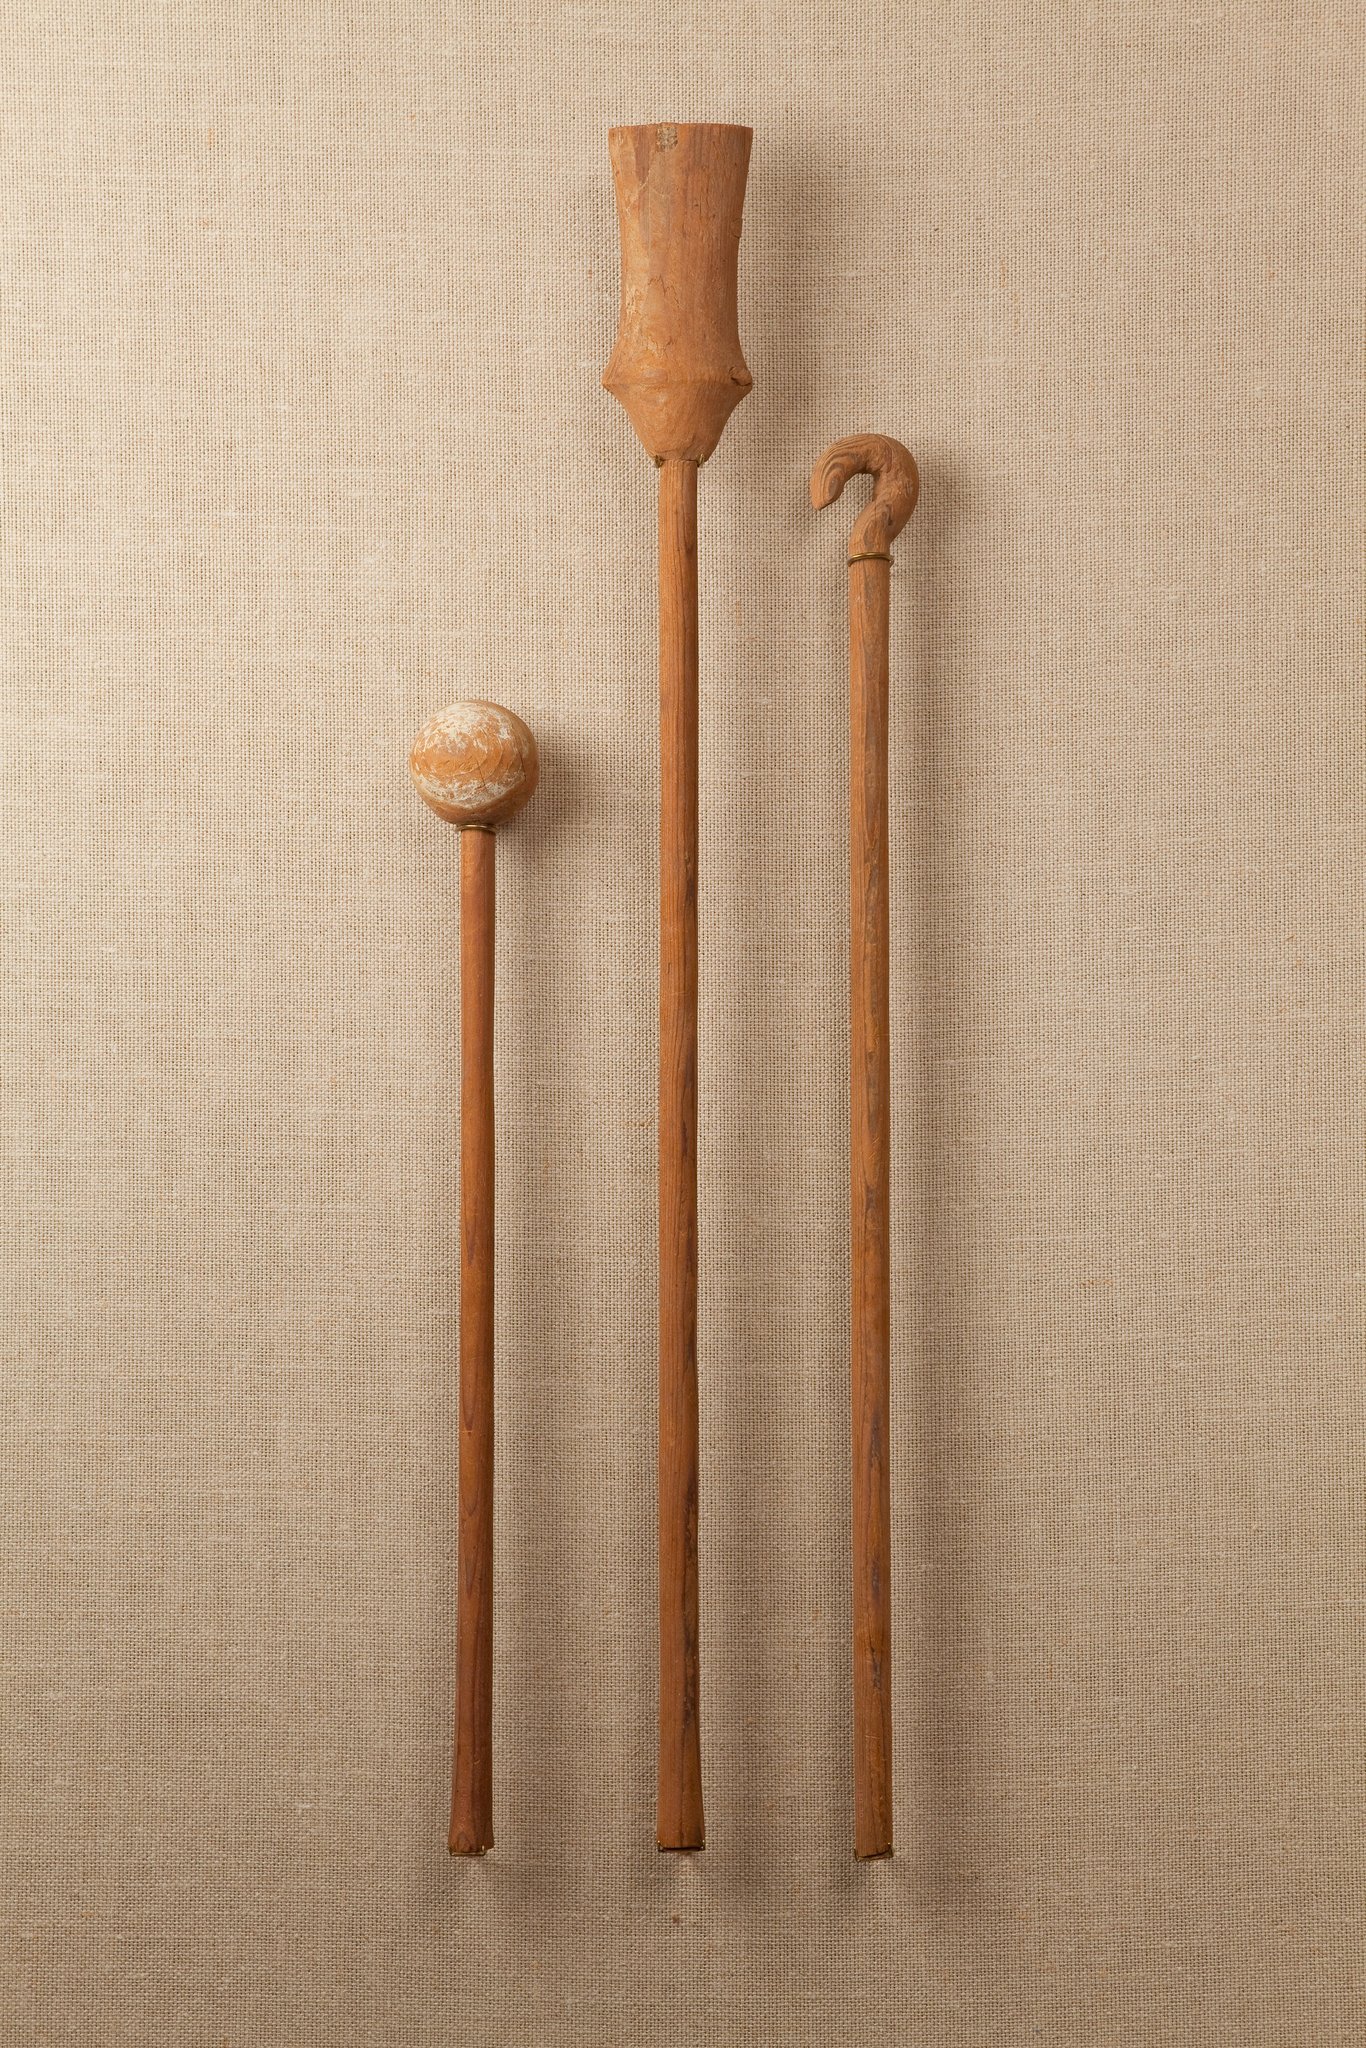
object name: model mace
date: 1981-1802 BCE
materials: paint, wood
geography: egypt